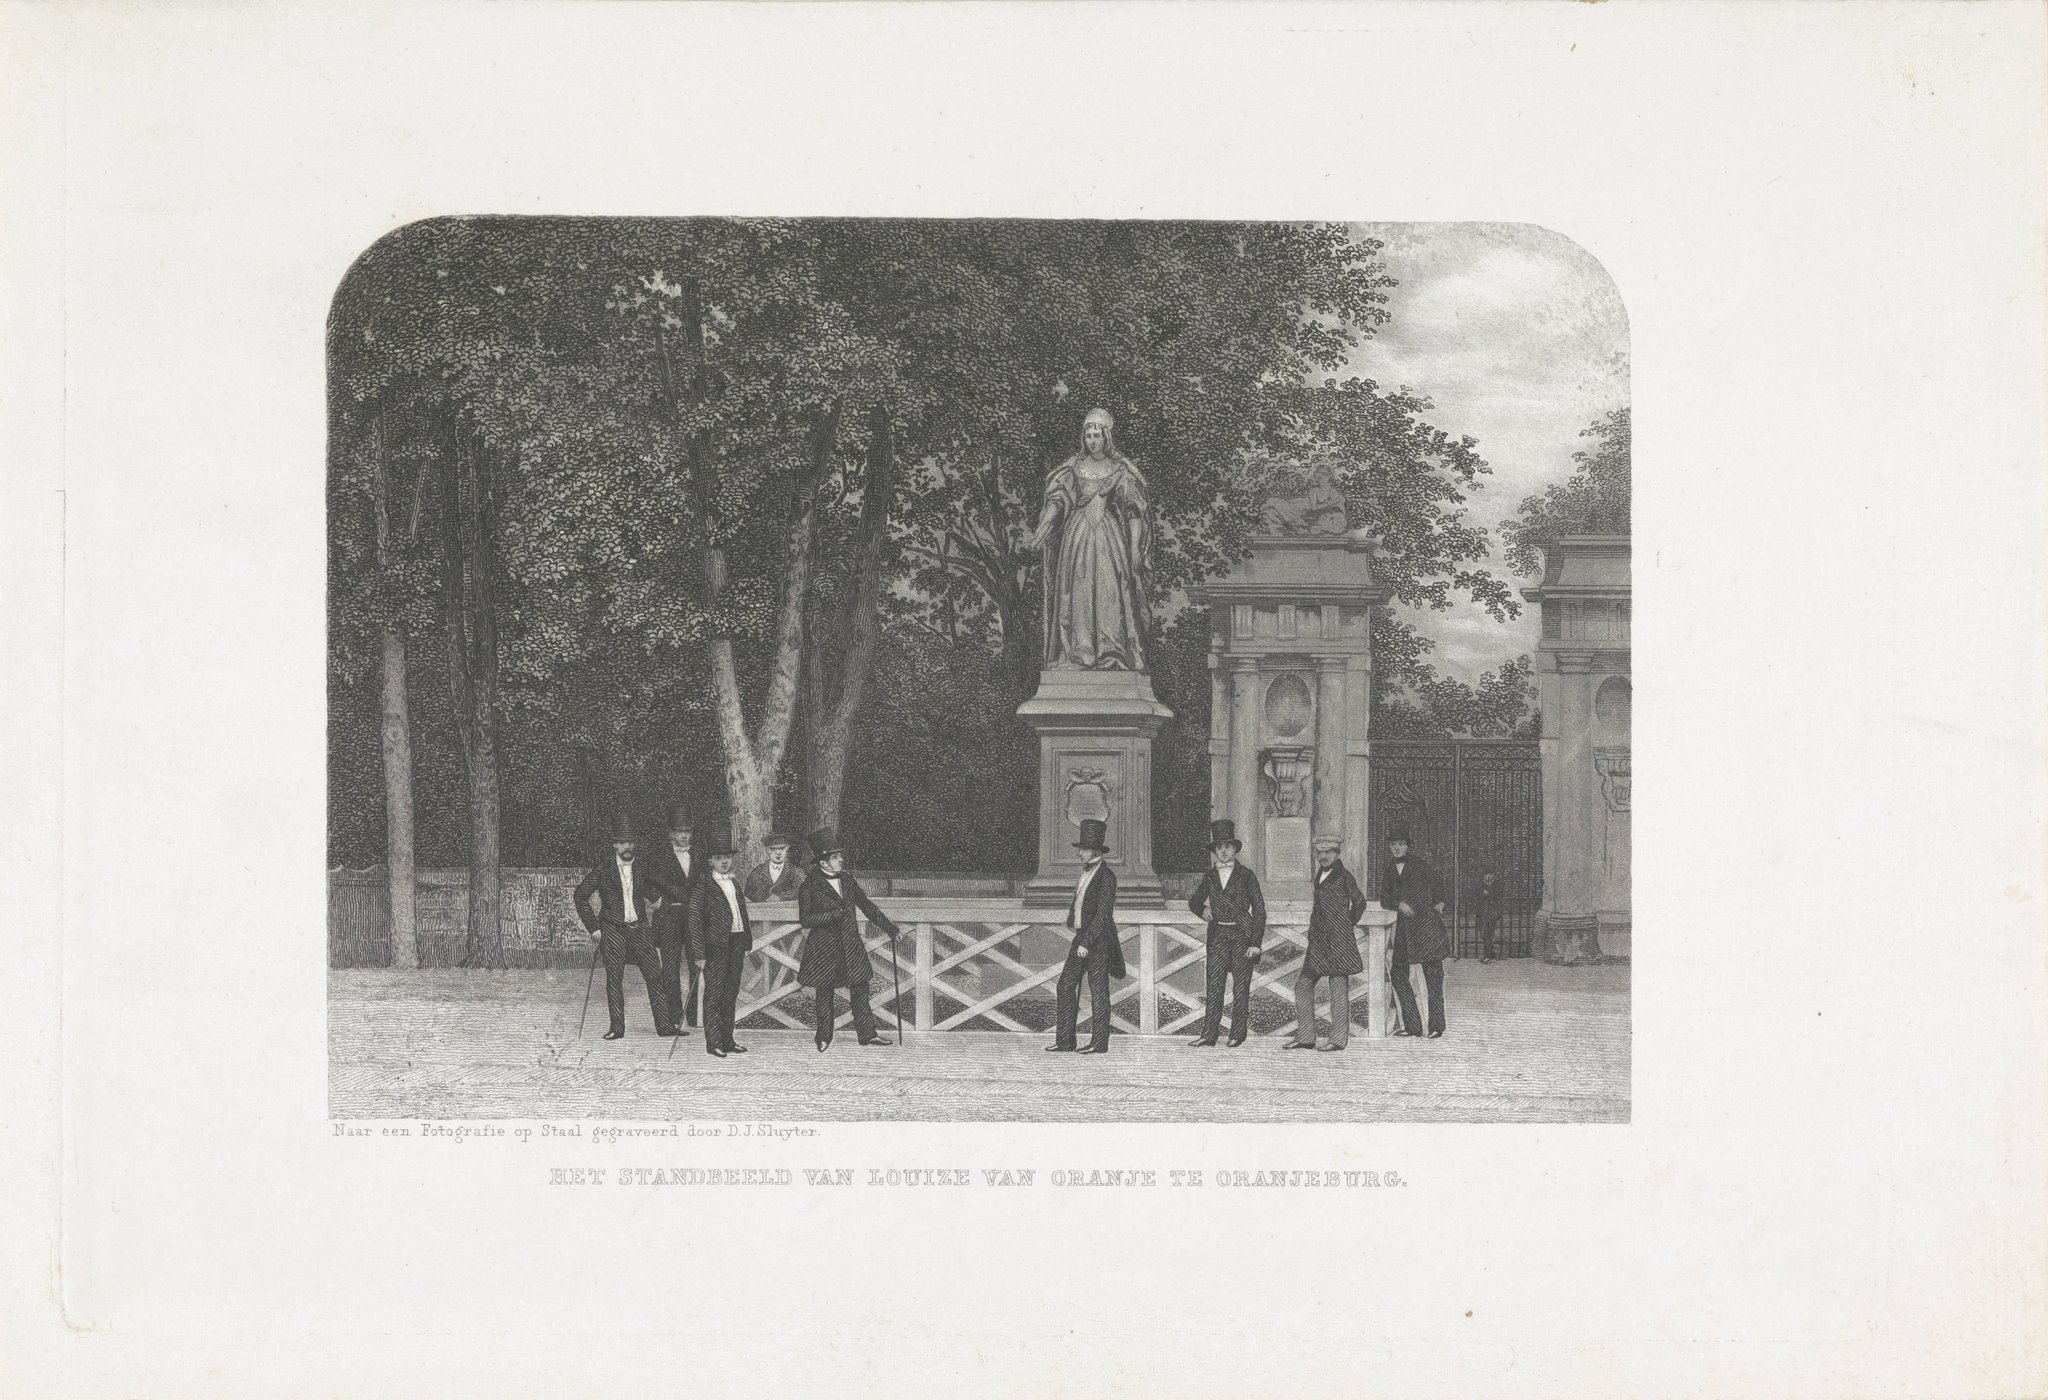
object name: print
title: Standbeeld van Louise Henriëtte, prinses van Oranje, te Oranienburg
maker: dirk jurriaan sluyter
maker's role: draughtsman, print maker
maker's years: 1811-1886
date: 1858-1871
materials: paper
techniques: engraving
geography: amsterdam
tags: the hague, berlin, louise henriëtte (prinses van oranje), monument, statue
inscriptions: collector's mark: Lugt 963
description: De hier vermelde titel verwijst naar de hoogst verkregen titel van de geportretteerde, niet per se naar de titel die de geportretteerde op deze voorstelling draagt.